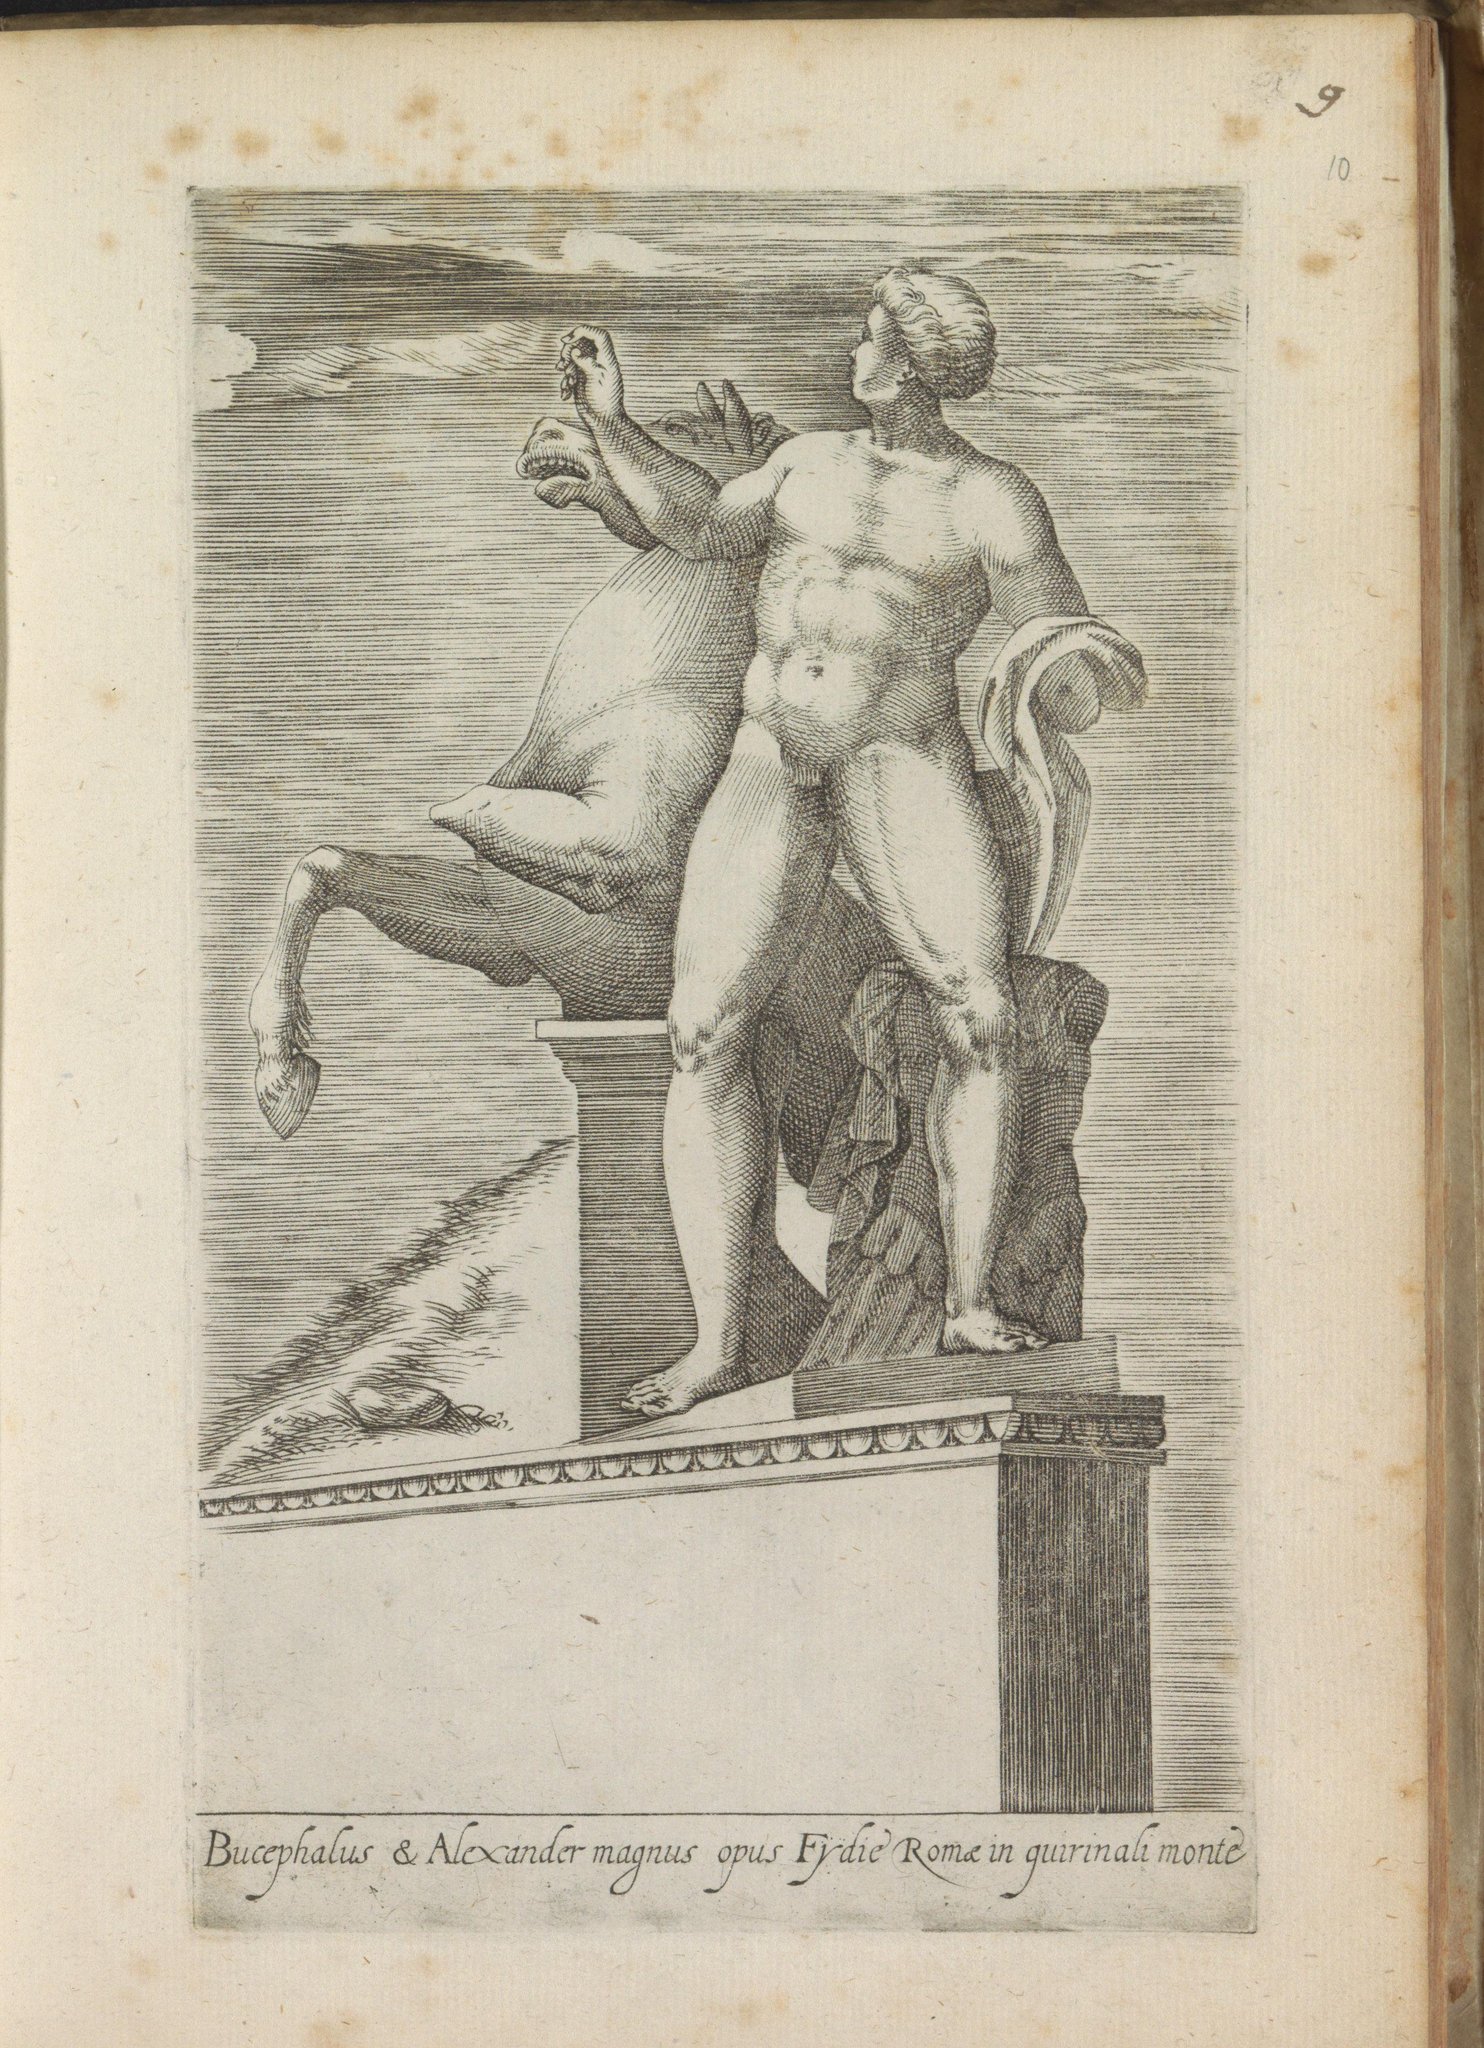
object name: print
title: Bucephalus & Alexander magnus opus (...)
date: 1584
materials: paper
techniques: engraving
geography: rome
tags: piece of sculpture, reproduction of a piece of sculpture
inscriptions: number: ‘9’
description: Een van de twee standbeelden van de Dioscuren (Castor en Pollux), twee naakte mannen met paarden. Voorheen geïnterpreteerd als de kunstenaars Pheidias en Praxiteles. De beelden staan op het Piazza del Quirinale in Rome. Onderschrift in het Latijn. Prent maakt deel uit van een album.